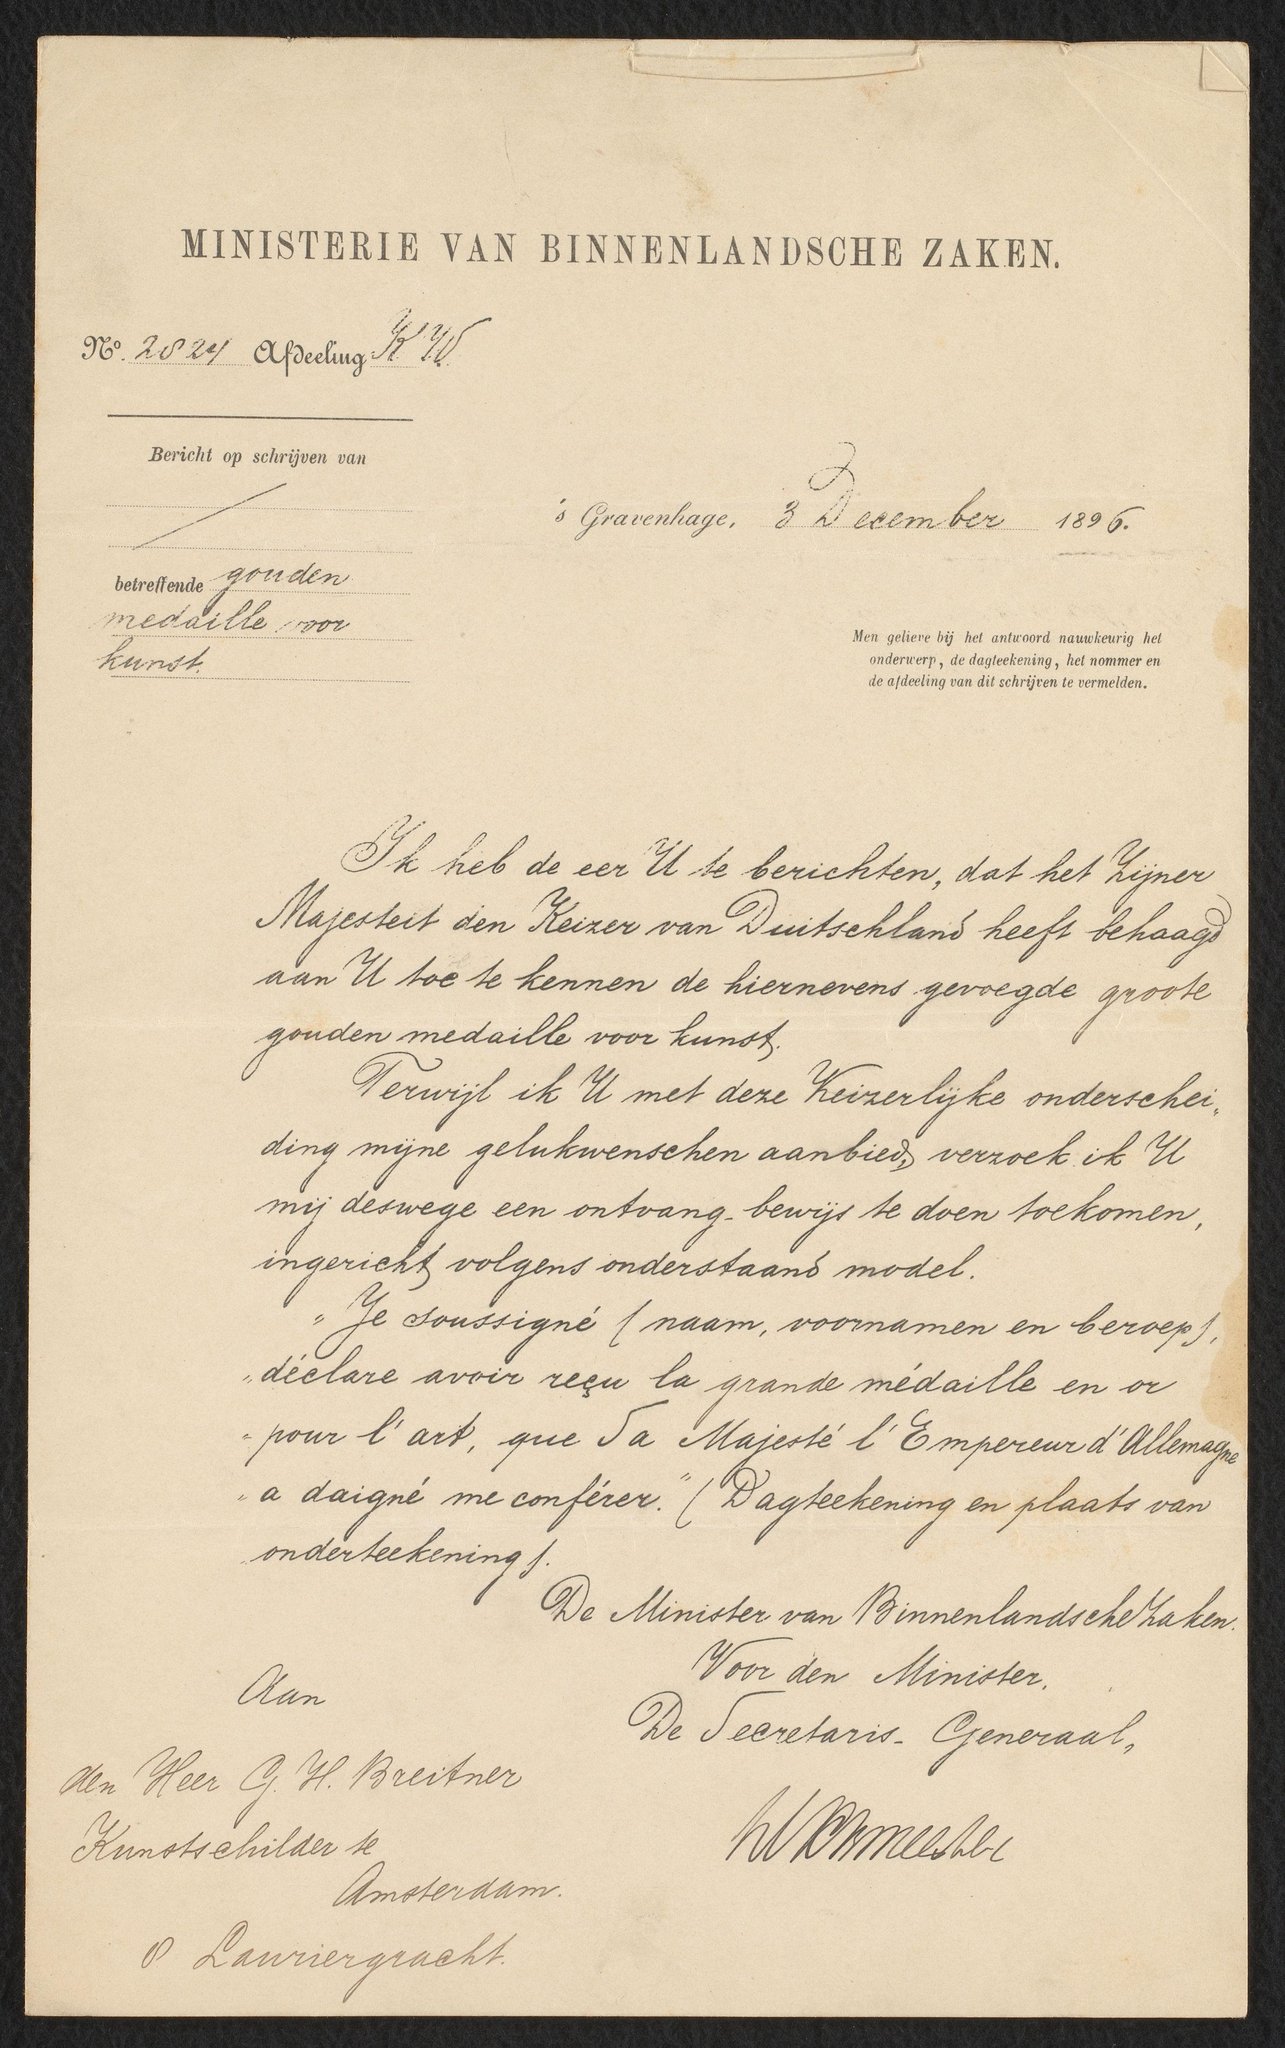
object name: letter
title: Brief gericht aan George Hendrik Breitner, afkomstig van het Ministerie van Binnenlandsche Zaken, betreffende het winnen van een gouden medaille toegekend door de Duitse keizer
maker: Anonymous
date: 1896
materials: ink, paper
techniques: letterpress printing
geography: the hague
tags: rotterdam, amsterdam, print maker, george hendrik breitner, distribution of awards ~ art contest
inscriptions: inscription: ‘[...] 96 [?]’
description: Brief gericht aan George Hendrik Breitner, ondertekend namens de minister van Binnenlandse Zaken, met mededeling dat George Hendrik Breitner een gouden medaille heeft gewonnen, toegekend door de Duitse keizer.